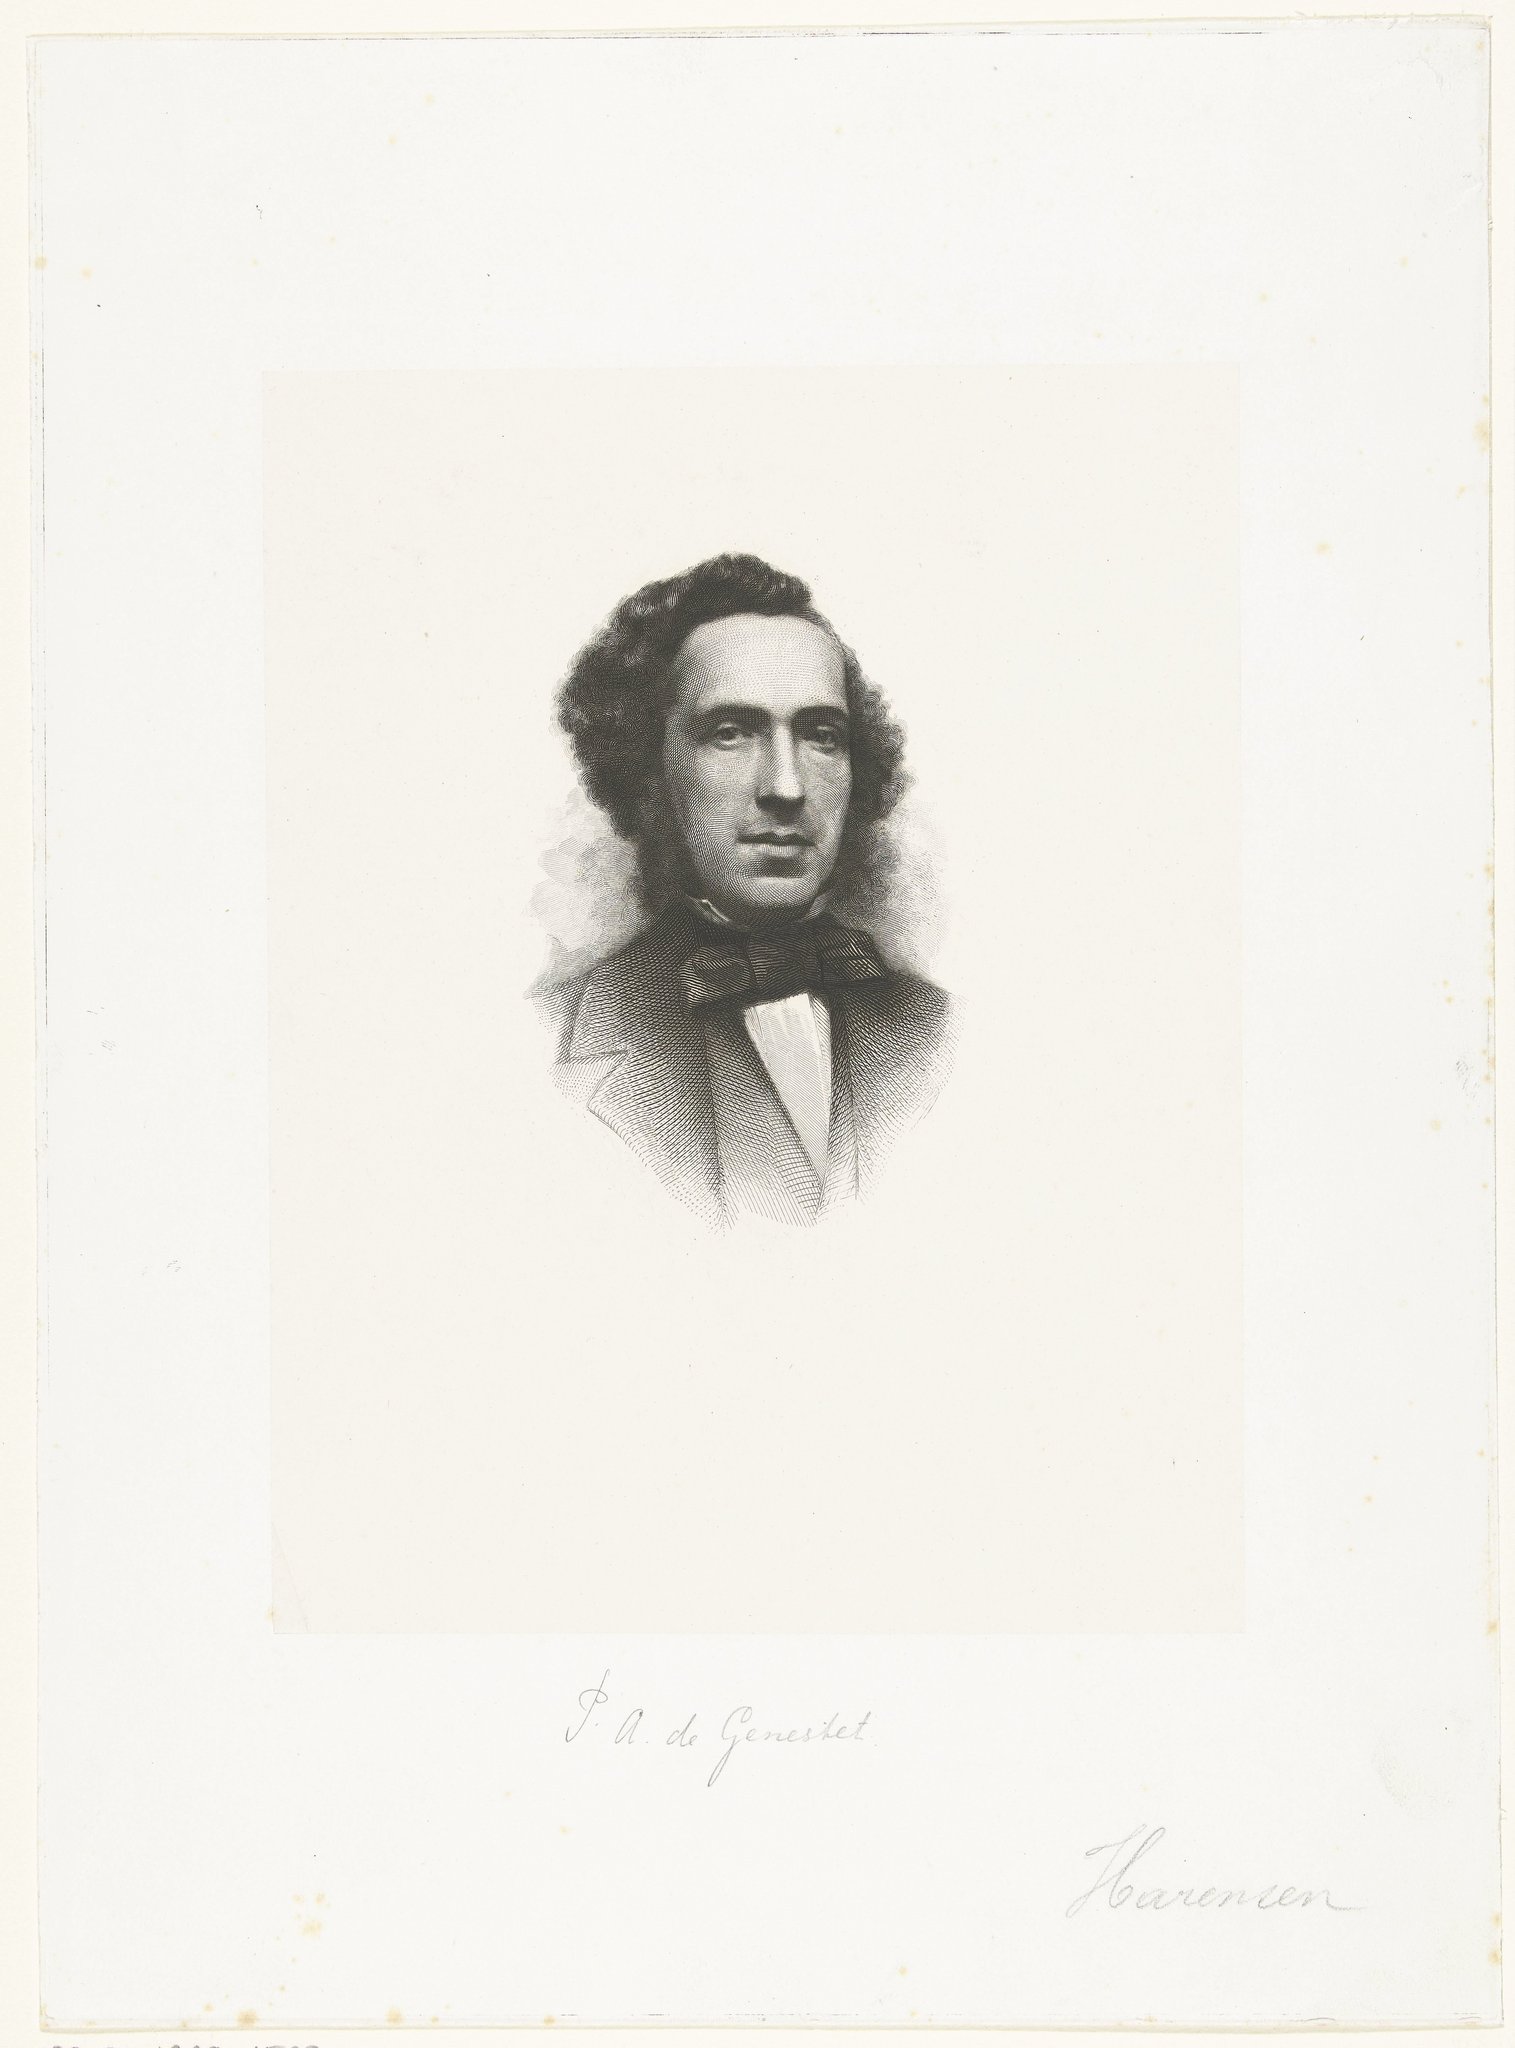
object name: print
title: Portret van Petrus Augustus de Genestet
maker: petrus johannes arendzen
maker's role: draughtsman, print maker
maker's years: 1846-1932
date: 1856-1861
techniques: printmaking, engraving, etching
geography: netherlands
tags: amsterdam, petrus augustus de génestet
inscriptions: collector's mark: Lugt 2228